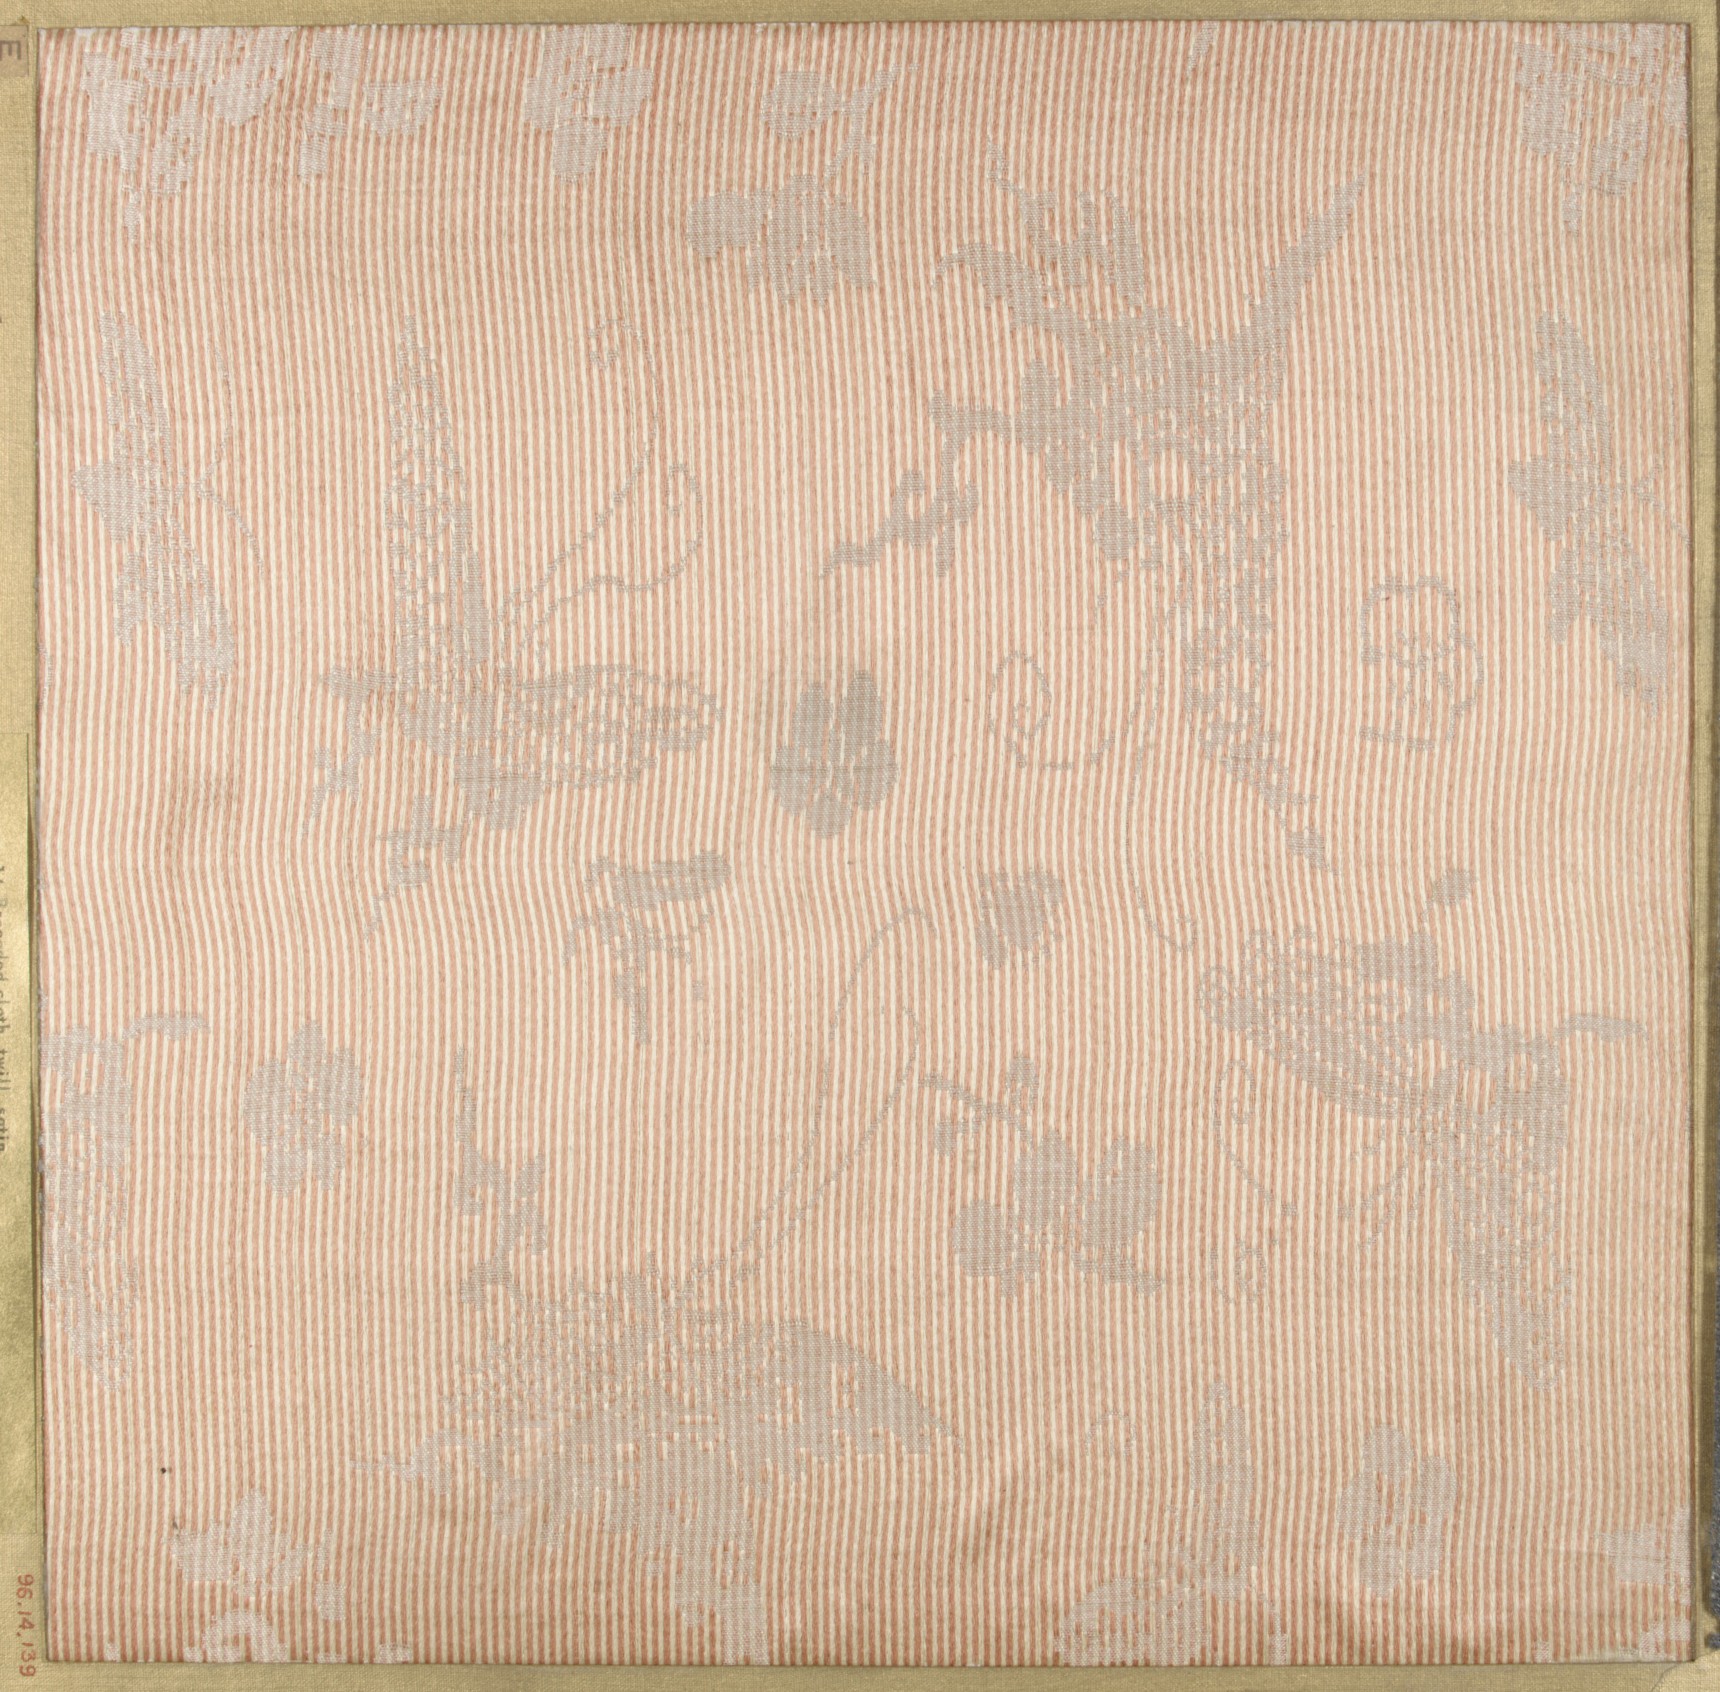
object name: piece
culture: japanese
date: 1701-1900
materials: silk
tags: flowers